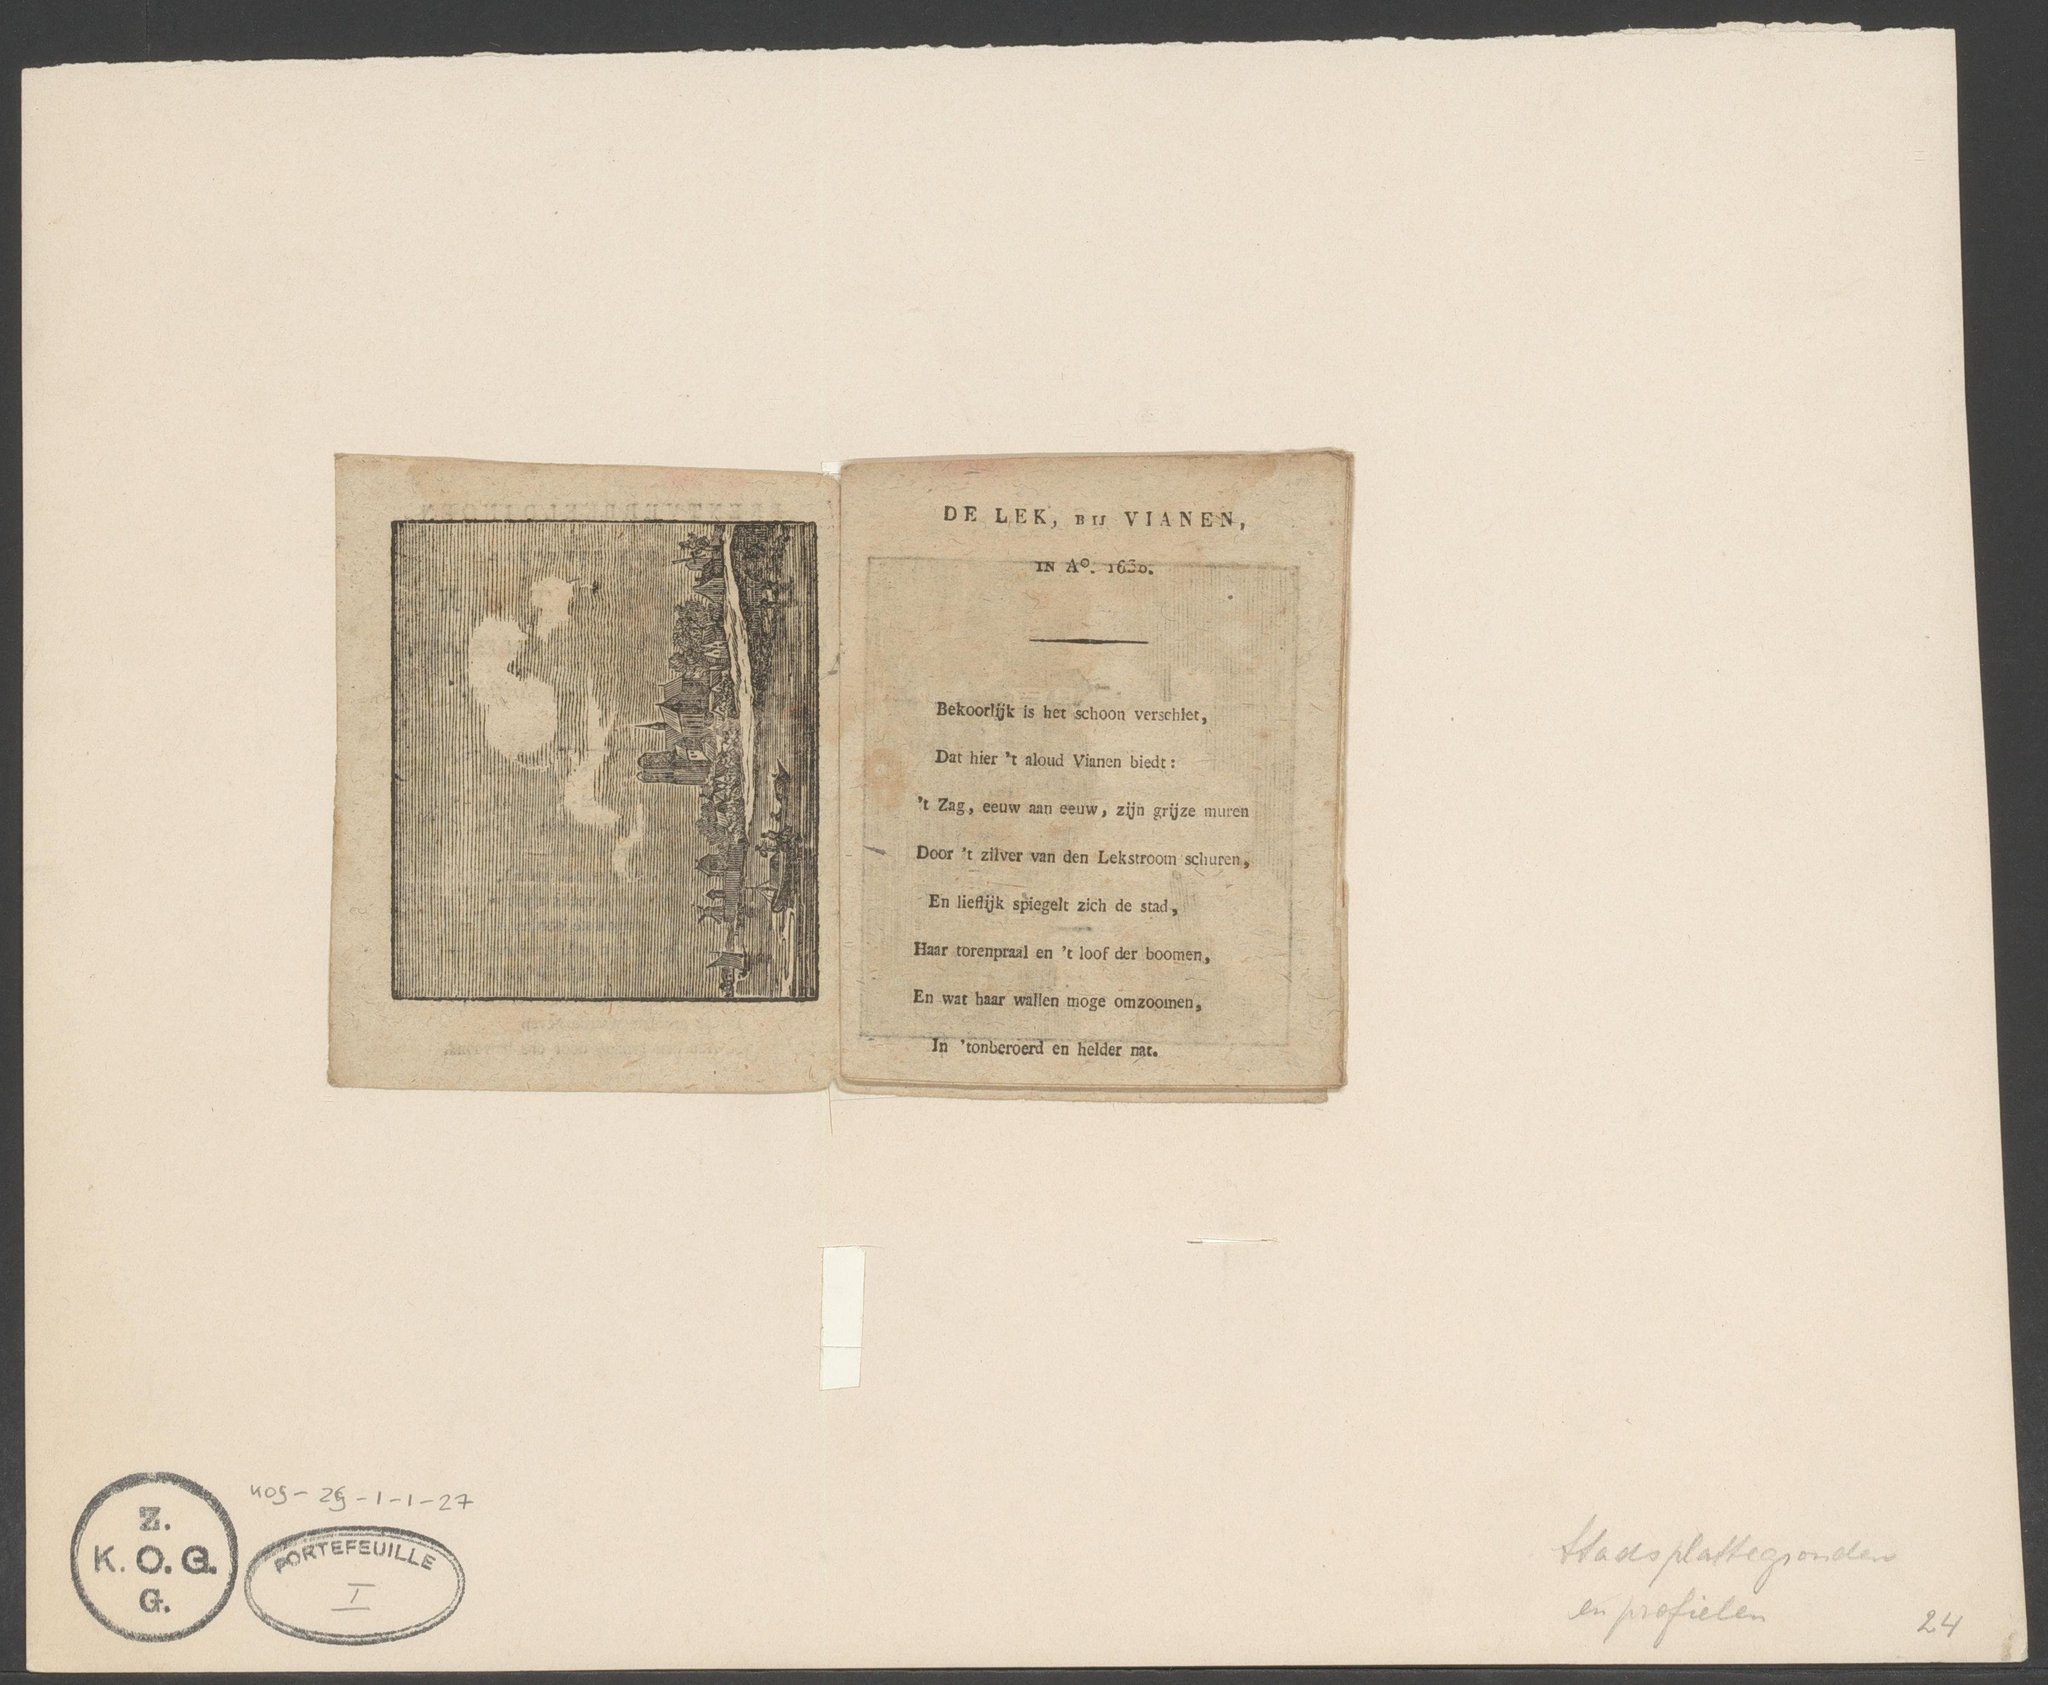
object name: print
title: Prentverbeeldingen van een zevental Gezigten op Rivieren van ons Vaderland; met toepasselijke Bijschriften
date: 1837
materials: paper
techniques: letterpress printing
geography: netherlands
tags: river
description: Rivierlandschap met de Lek bij Vianen. met achtregelig vers. Onderdeel van een gevouwen boekje met zeven gezichten met Nederlandse rivierlandschappen met bijpassende verzen met jaartallen. Onderwerpsrubrieken binnen de Atlas Zeden en Gewoonten: topografie.